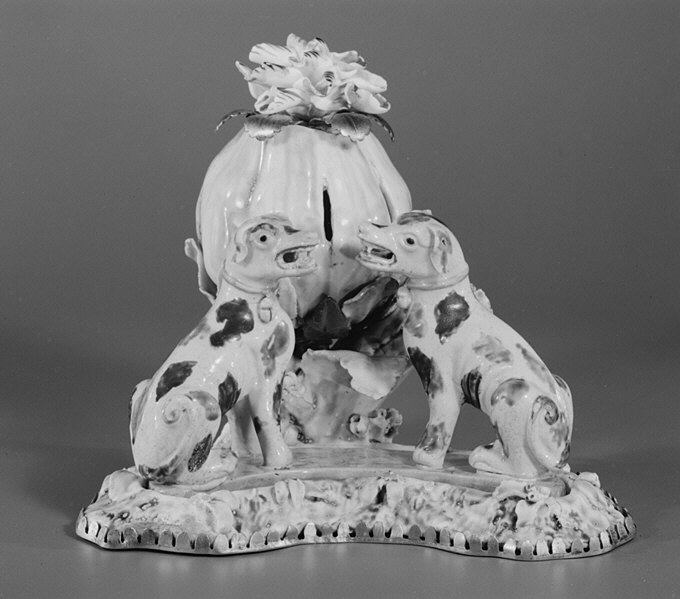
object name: perfume burner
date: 1701-1800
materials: gilt bronze, hard paste porcelain, soft paste porcelain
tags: dogs,flowers